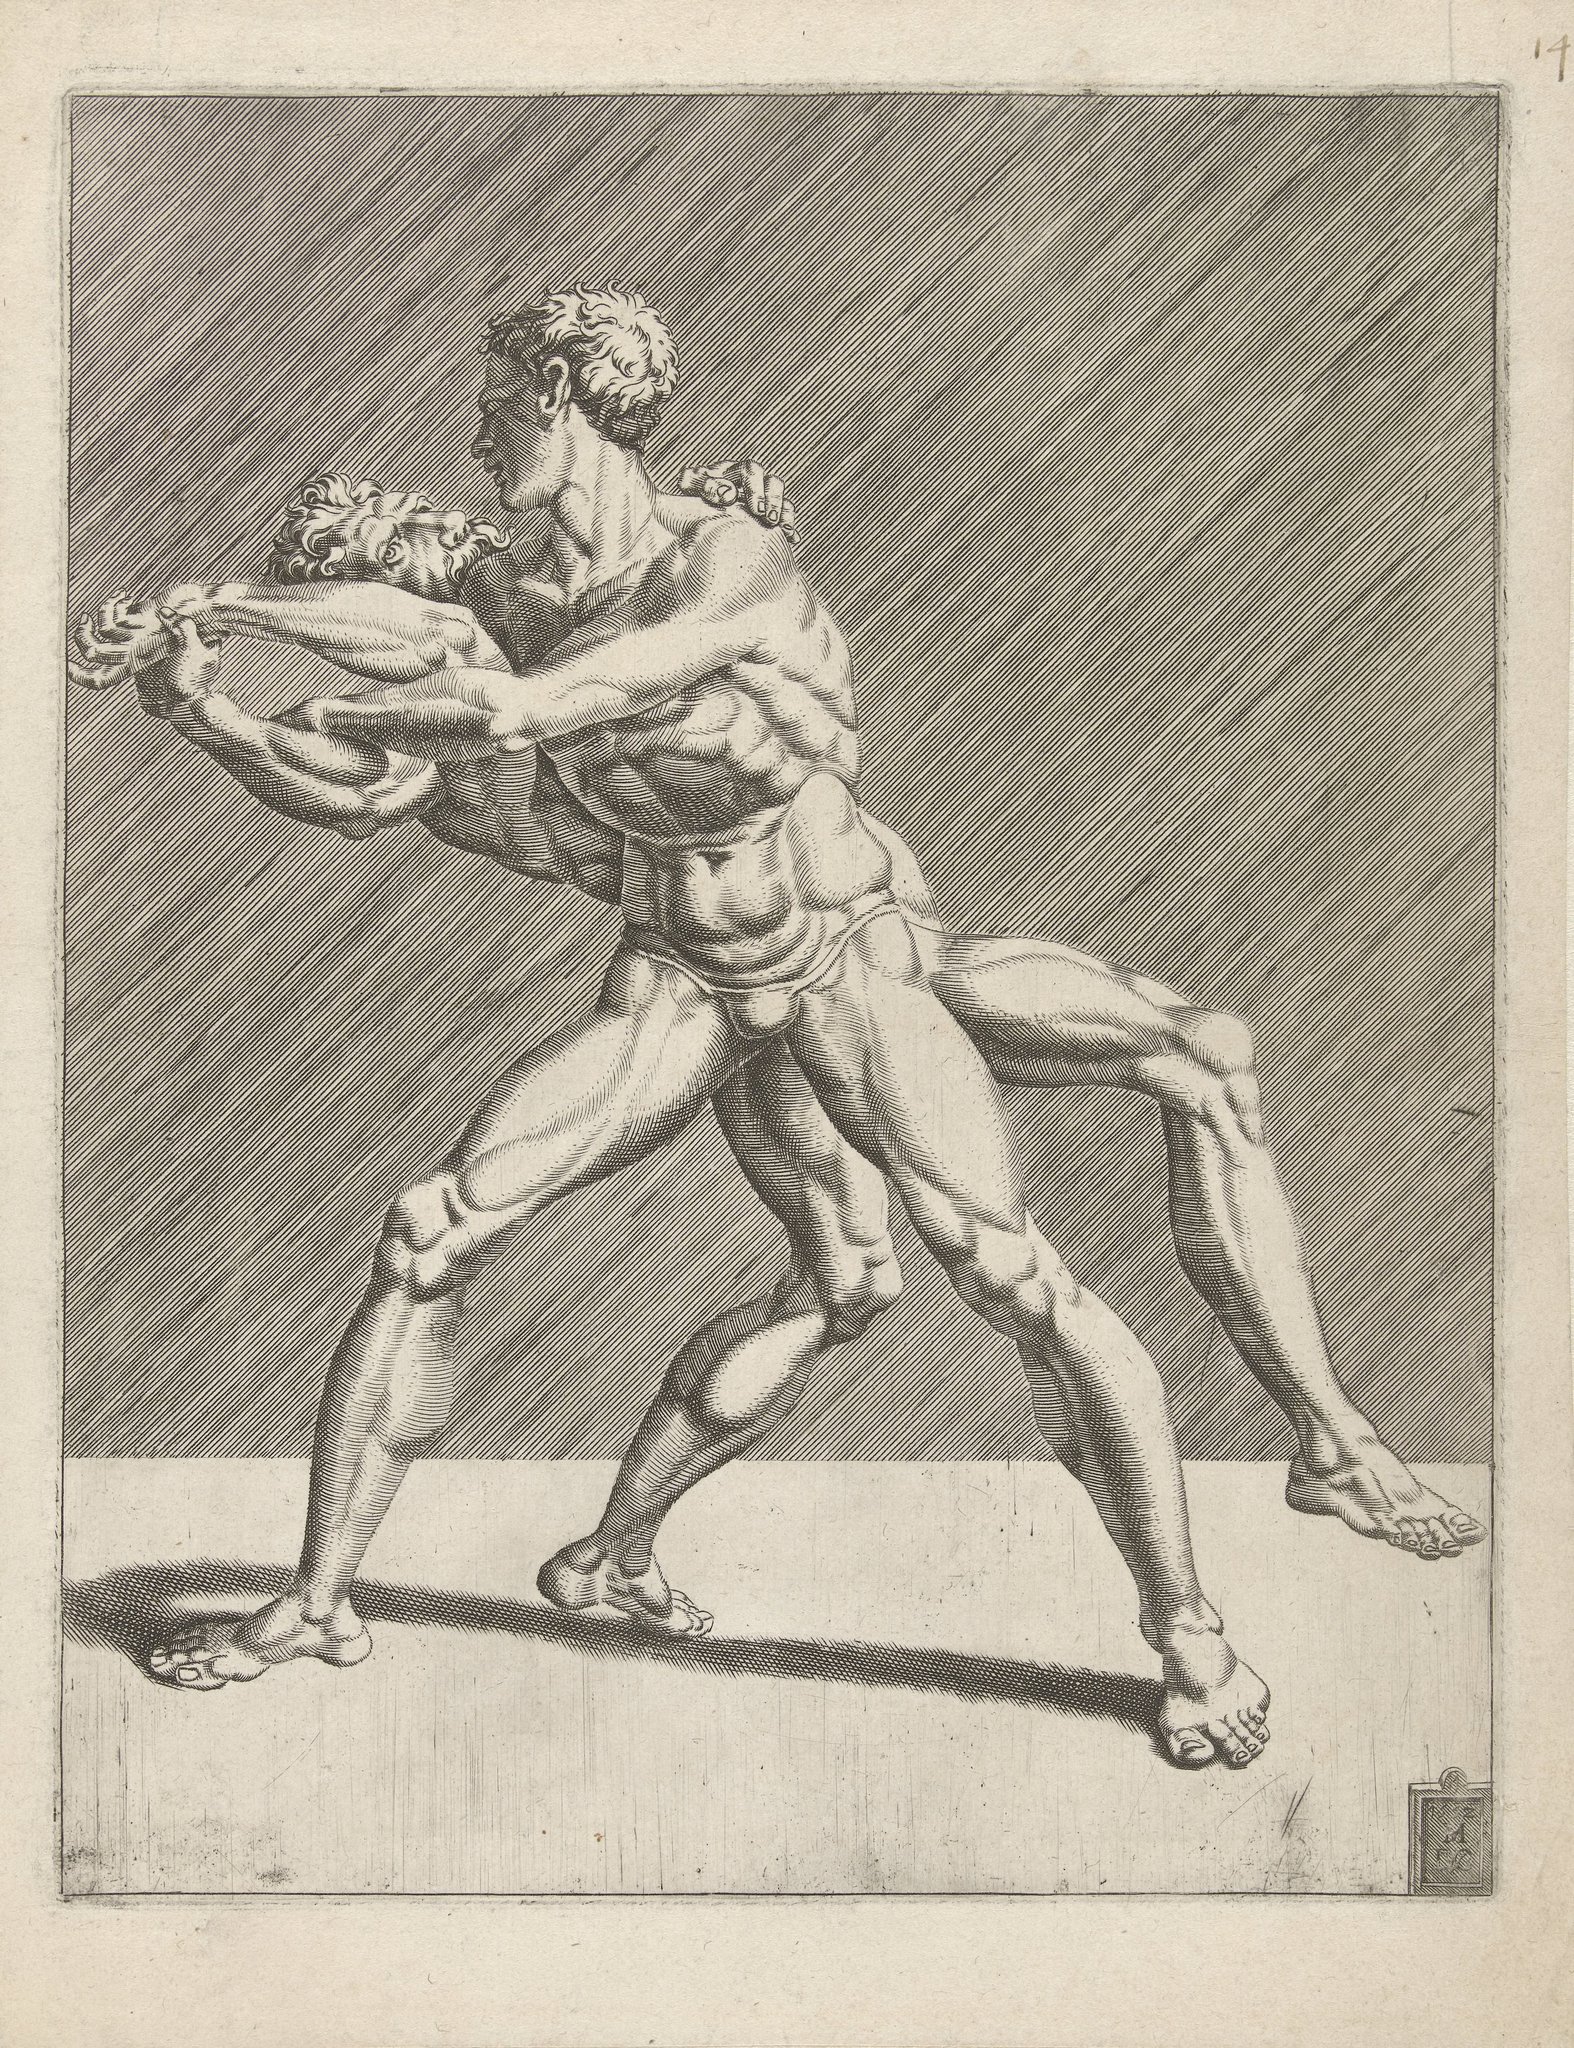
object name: print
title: Twee worstelaars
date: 1552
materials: paper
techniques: engraving, etching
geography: haarlem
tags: wrestling (sport)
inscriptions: collector's mark: Lugt 2760, collector's mark: Lugt 2228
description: Twee naakte worstelaars. De prent maakt deel uit van een serie over twee worstelaars in gevecht.